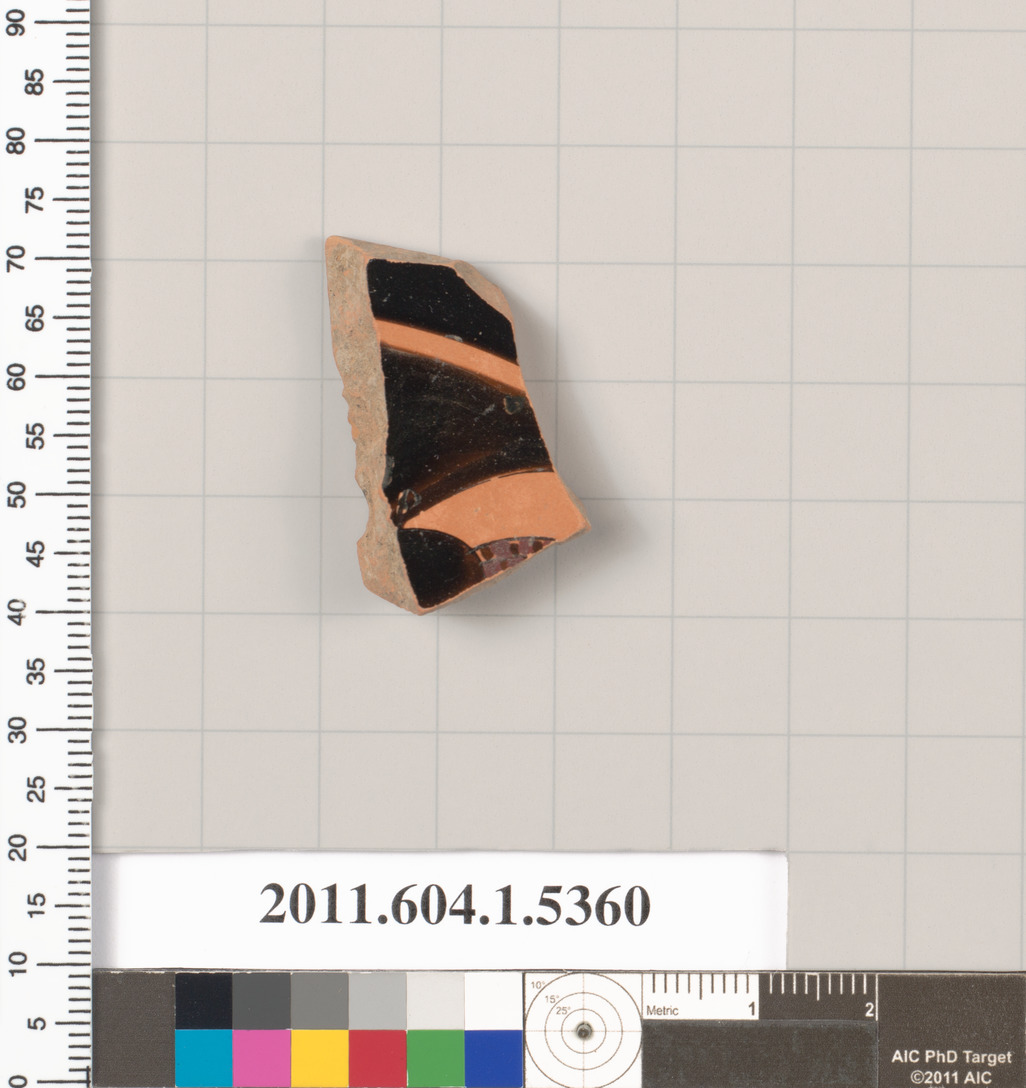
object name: kylix fragment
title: Terracotta fragment of a kylix (drinking cup)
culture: greek, attic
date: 520-500 BCE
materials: terracotta